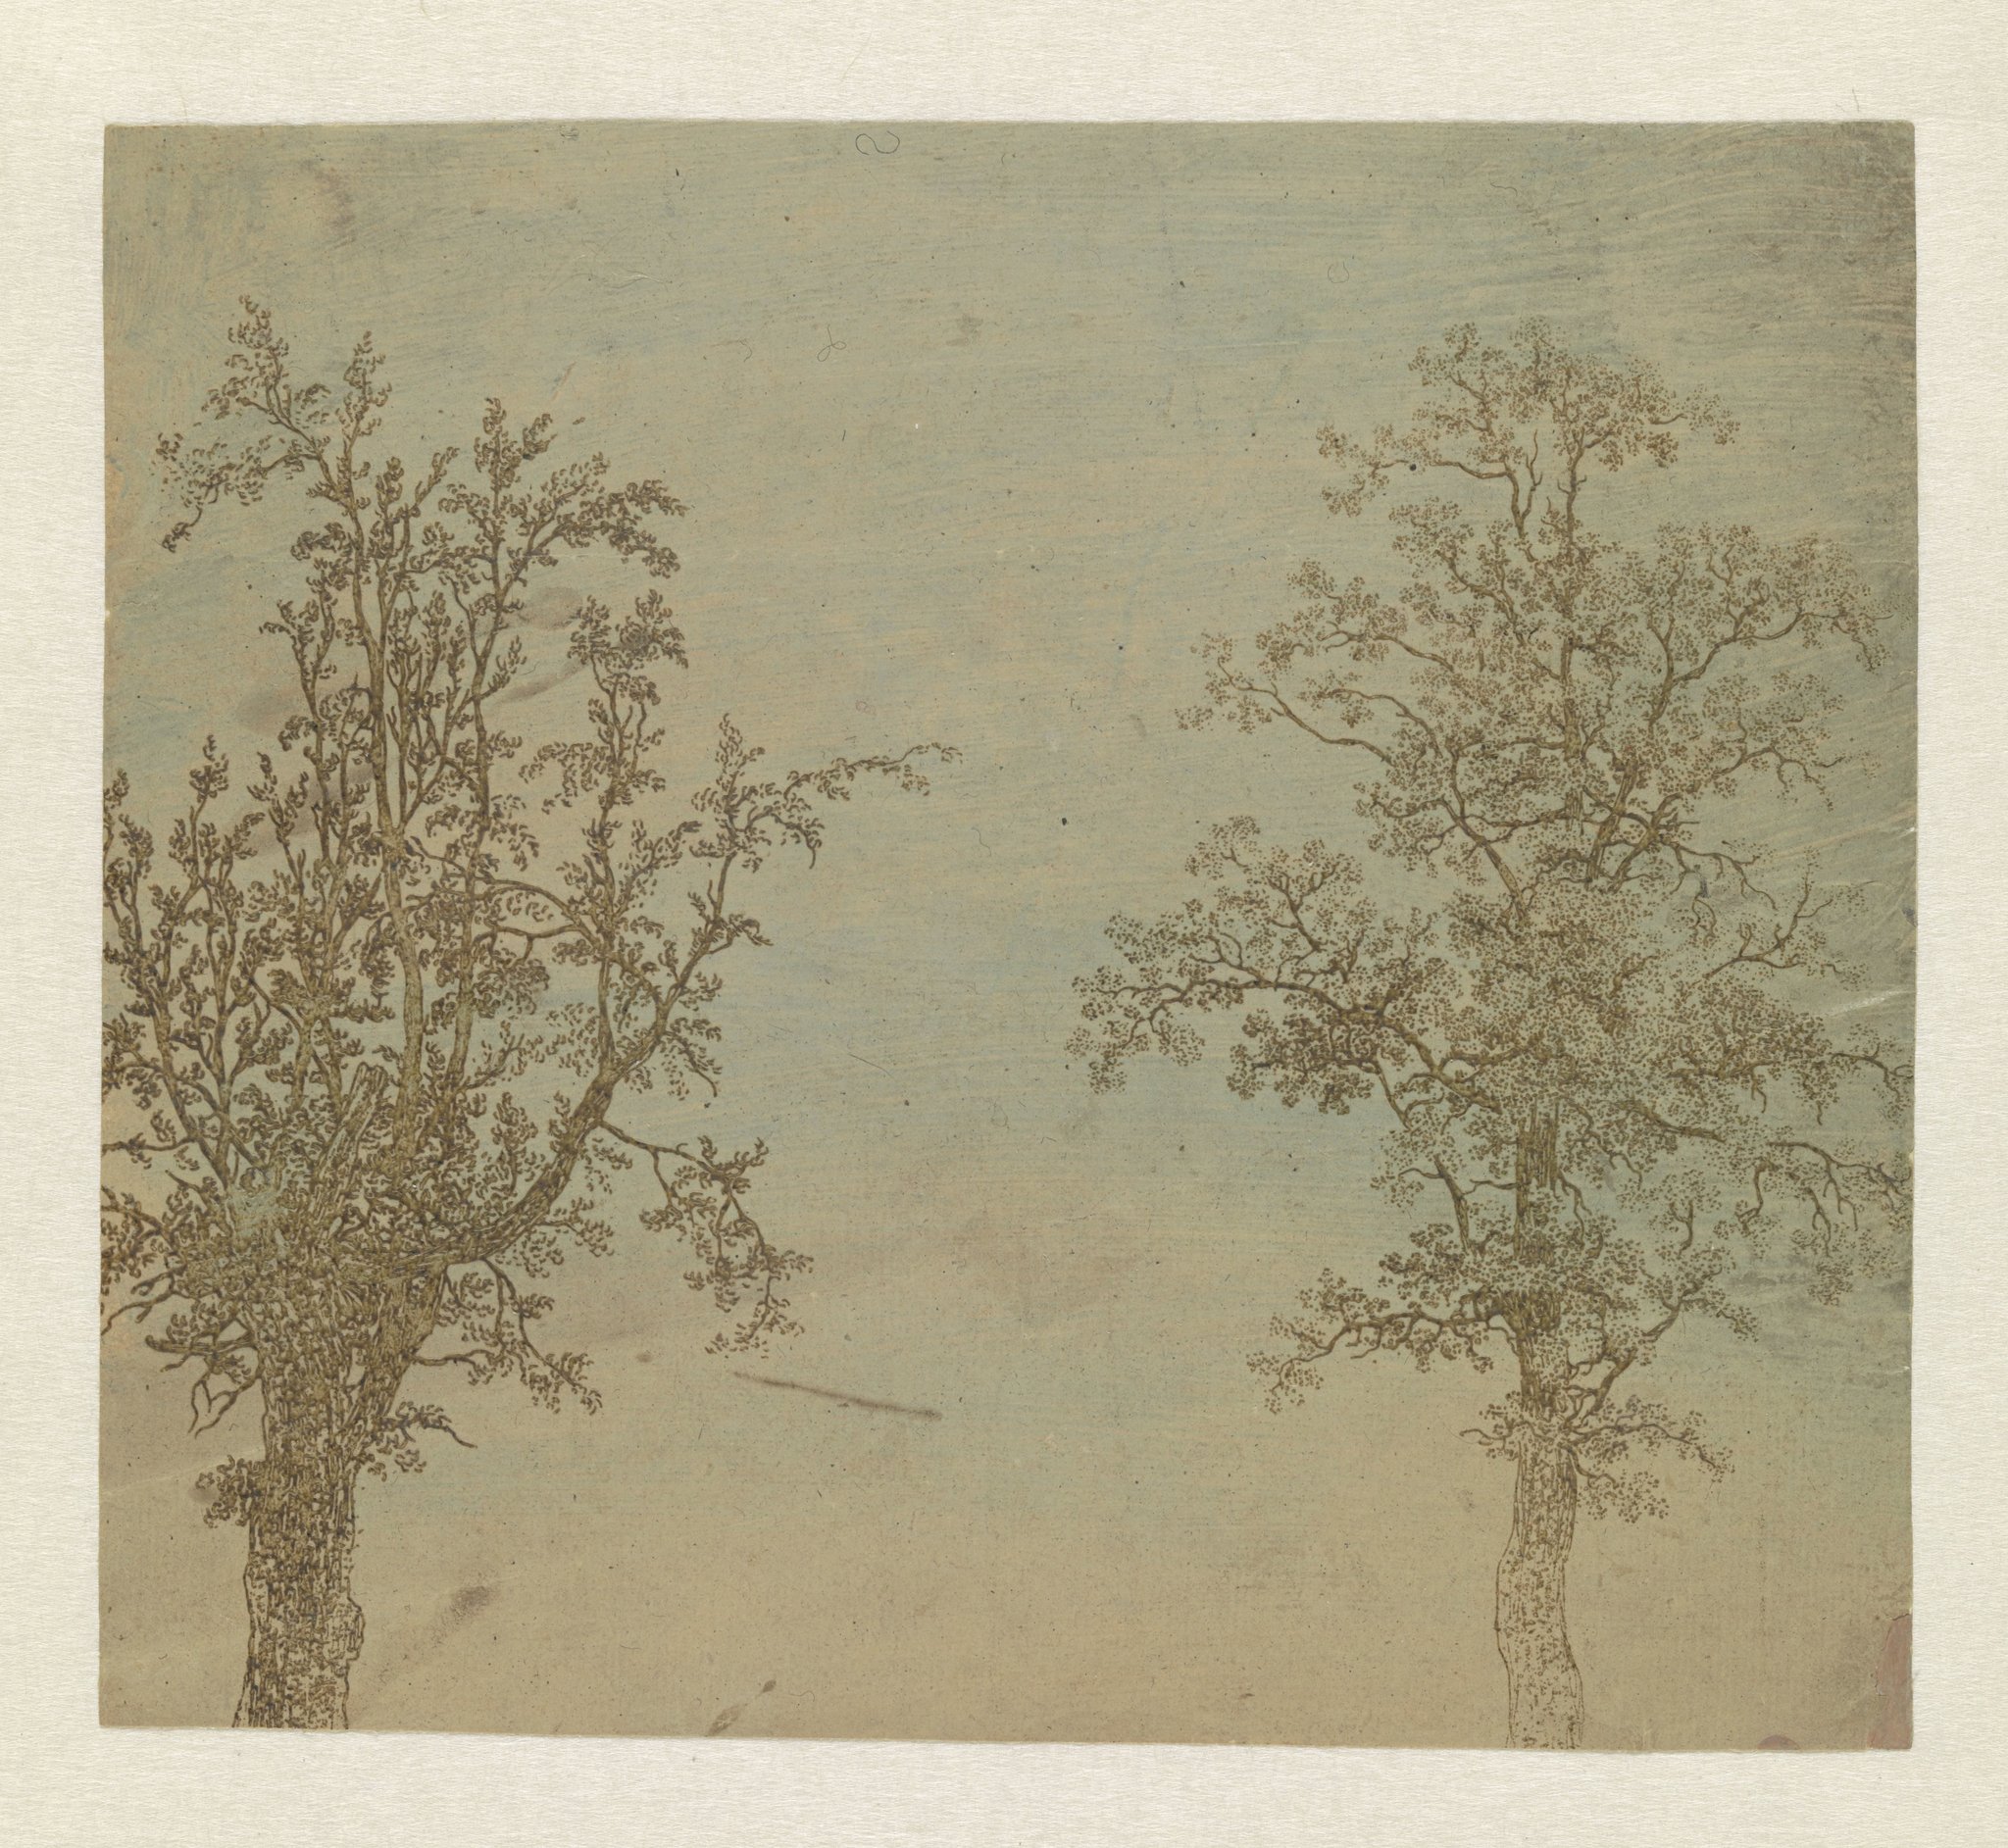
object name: print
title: The Two Trees (An Alder and an Ash)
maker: hercules segers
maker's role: draughtsman, painter, print maker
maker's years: 1589-1640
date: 1625-1630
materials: paper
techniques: hand coloring, lift ground etching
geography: amsterdam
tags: trees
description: The young alder and ash shown here are among the most convincing and original renderings of trees in 17th-century art. Both species abound in the river landscapes in which Segers travelled around.